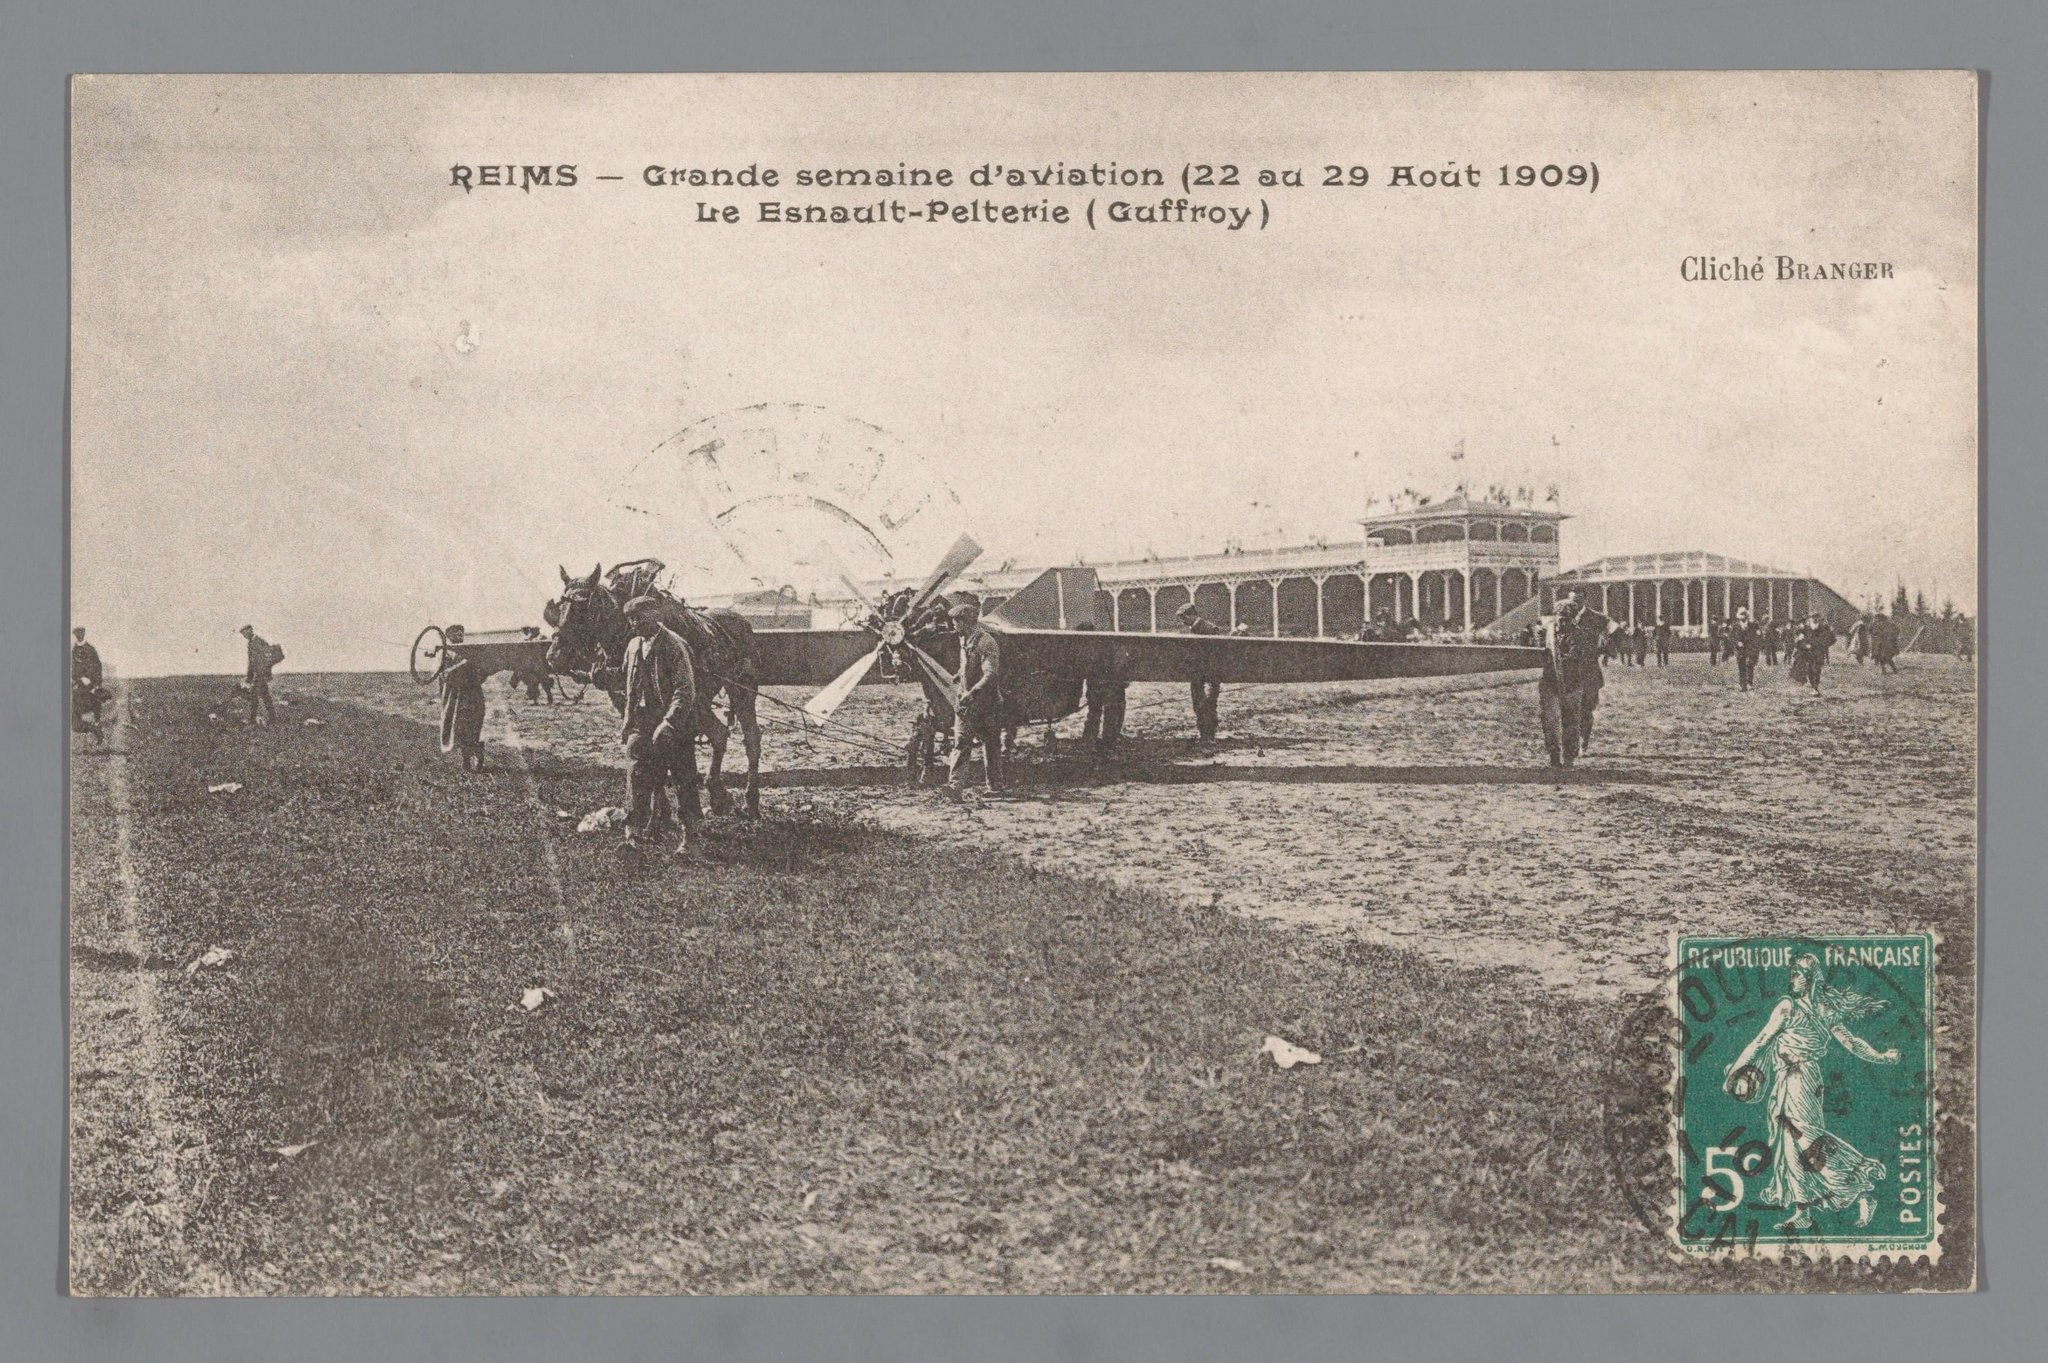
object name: ansichtkaart, prentbriefkaart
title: Reims - Grande semaine d'aviation (22 au 20 Août 1909) Le Esnault-Pelterie (Guffroy)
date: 1909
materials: paper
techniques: photograph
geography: reims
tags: aircraft, aeroplane, meadow, pasture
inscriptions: name: ‘Gustave Lefebvre 43, Rue Nationale Boulogne-sur-Mer’, inscription: ‘Monsieur J. F. Milders (..) Delft (Hollande)’